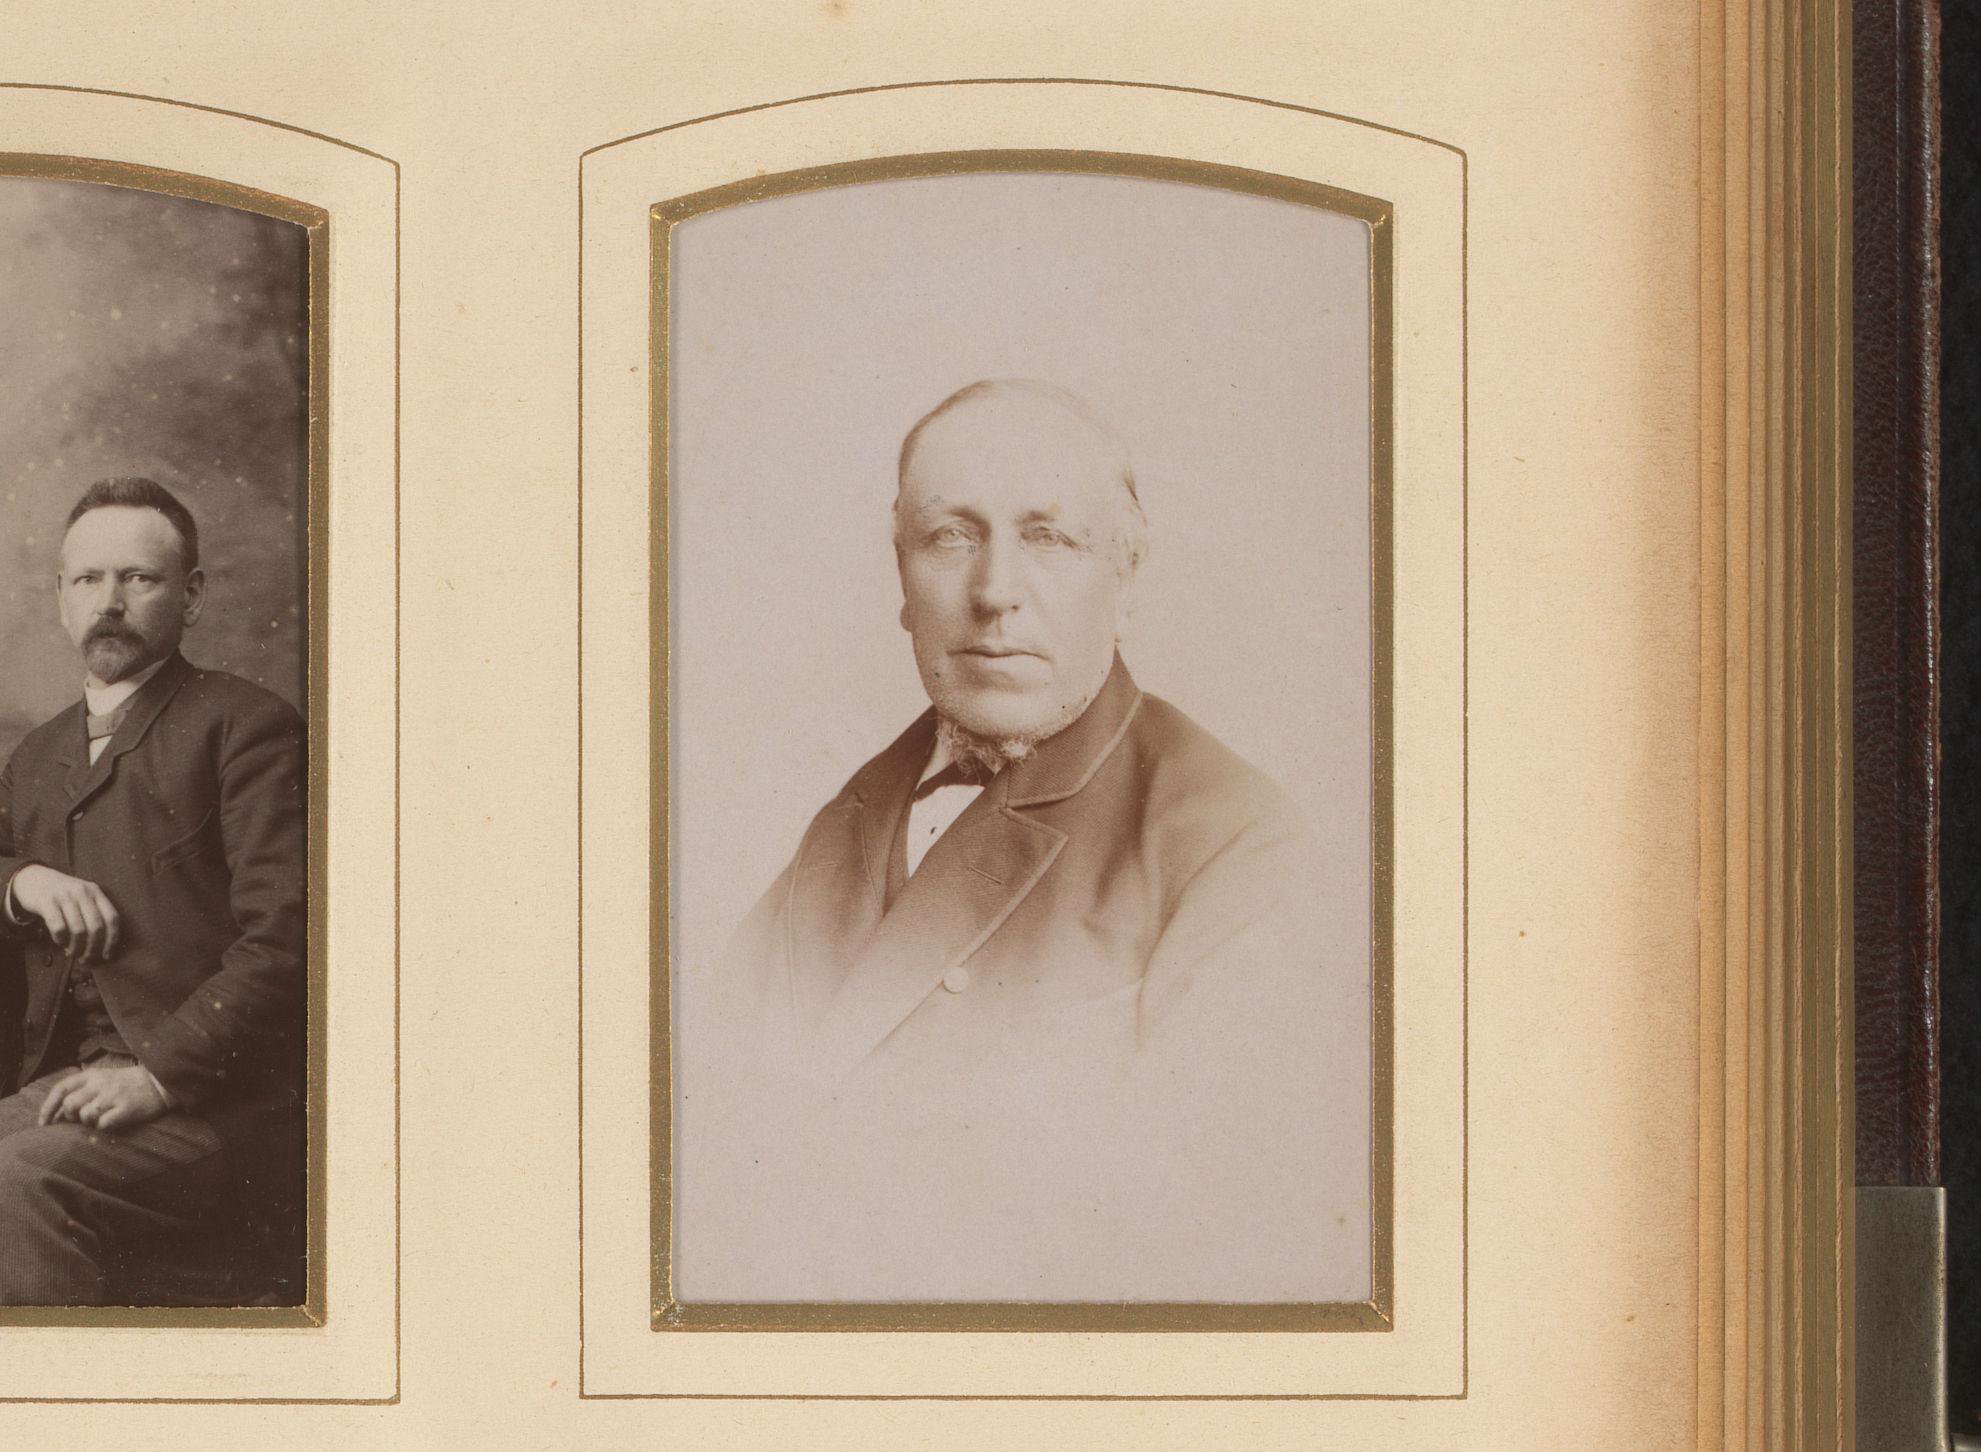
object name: photograph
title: Portret van een man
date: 1875-1899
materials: cardboard, photographic support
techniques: albumen print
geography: amsterdam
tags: historical persons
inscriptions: inscription: ‘Photographie/ Française/ 147/ Wamoesstraat/ AMSTERDAM’